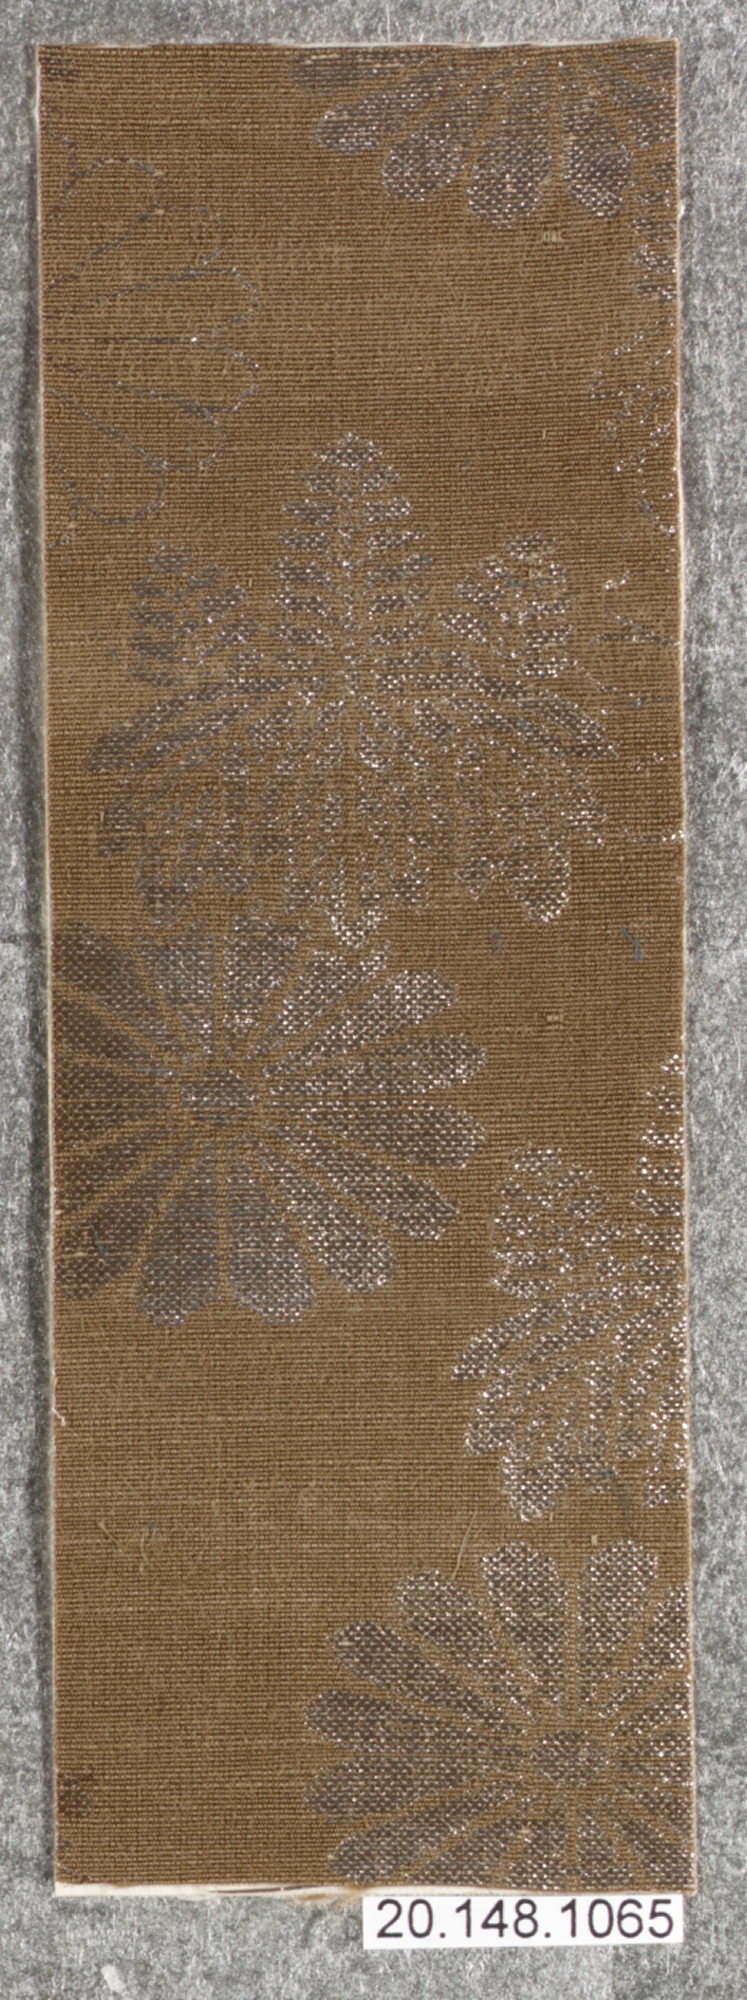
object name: piece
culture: chinese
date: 1701-1800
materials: silk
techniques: compound weave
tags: flowers